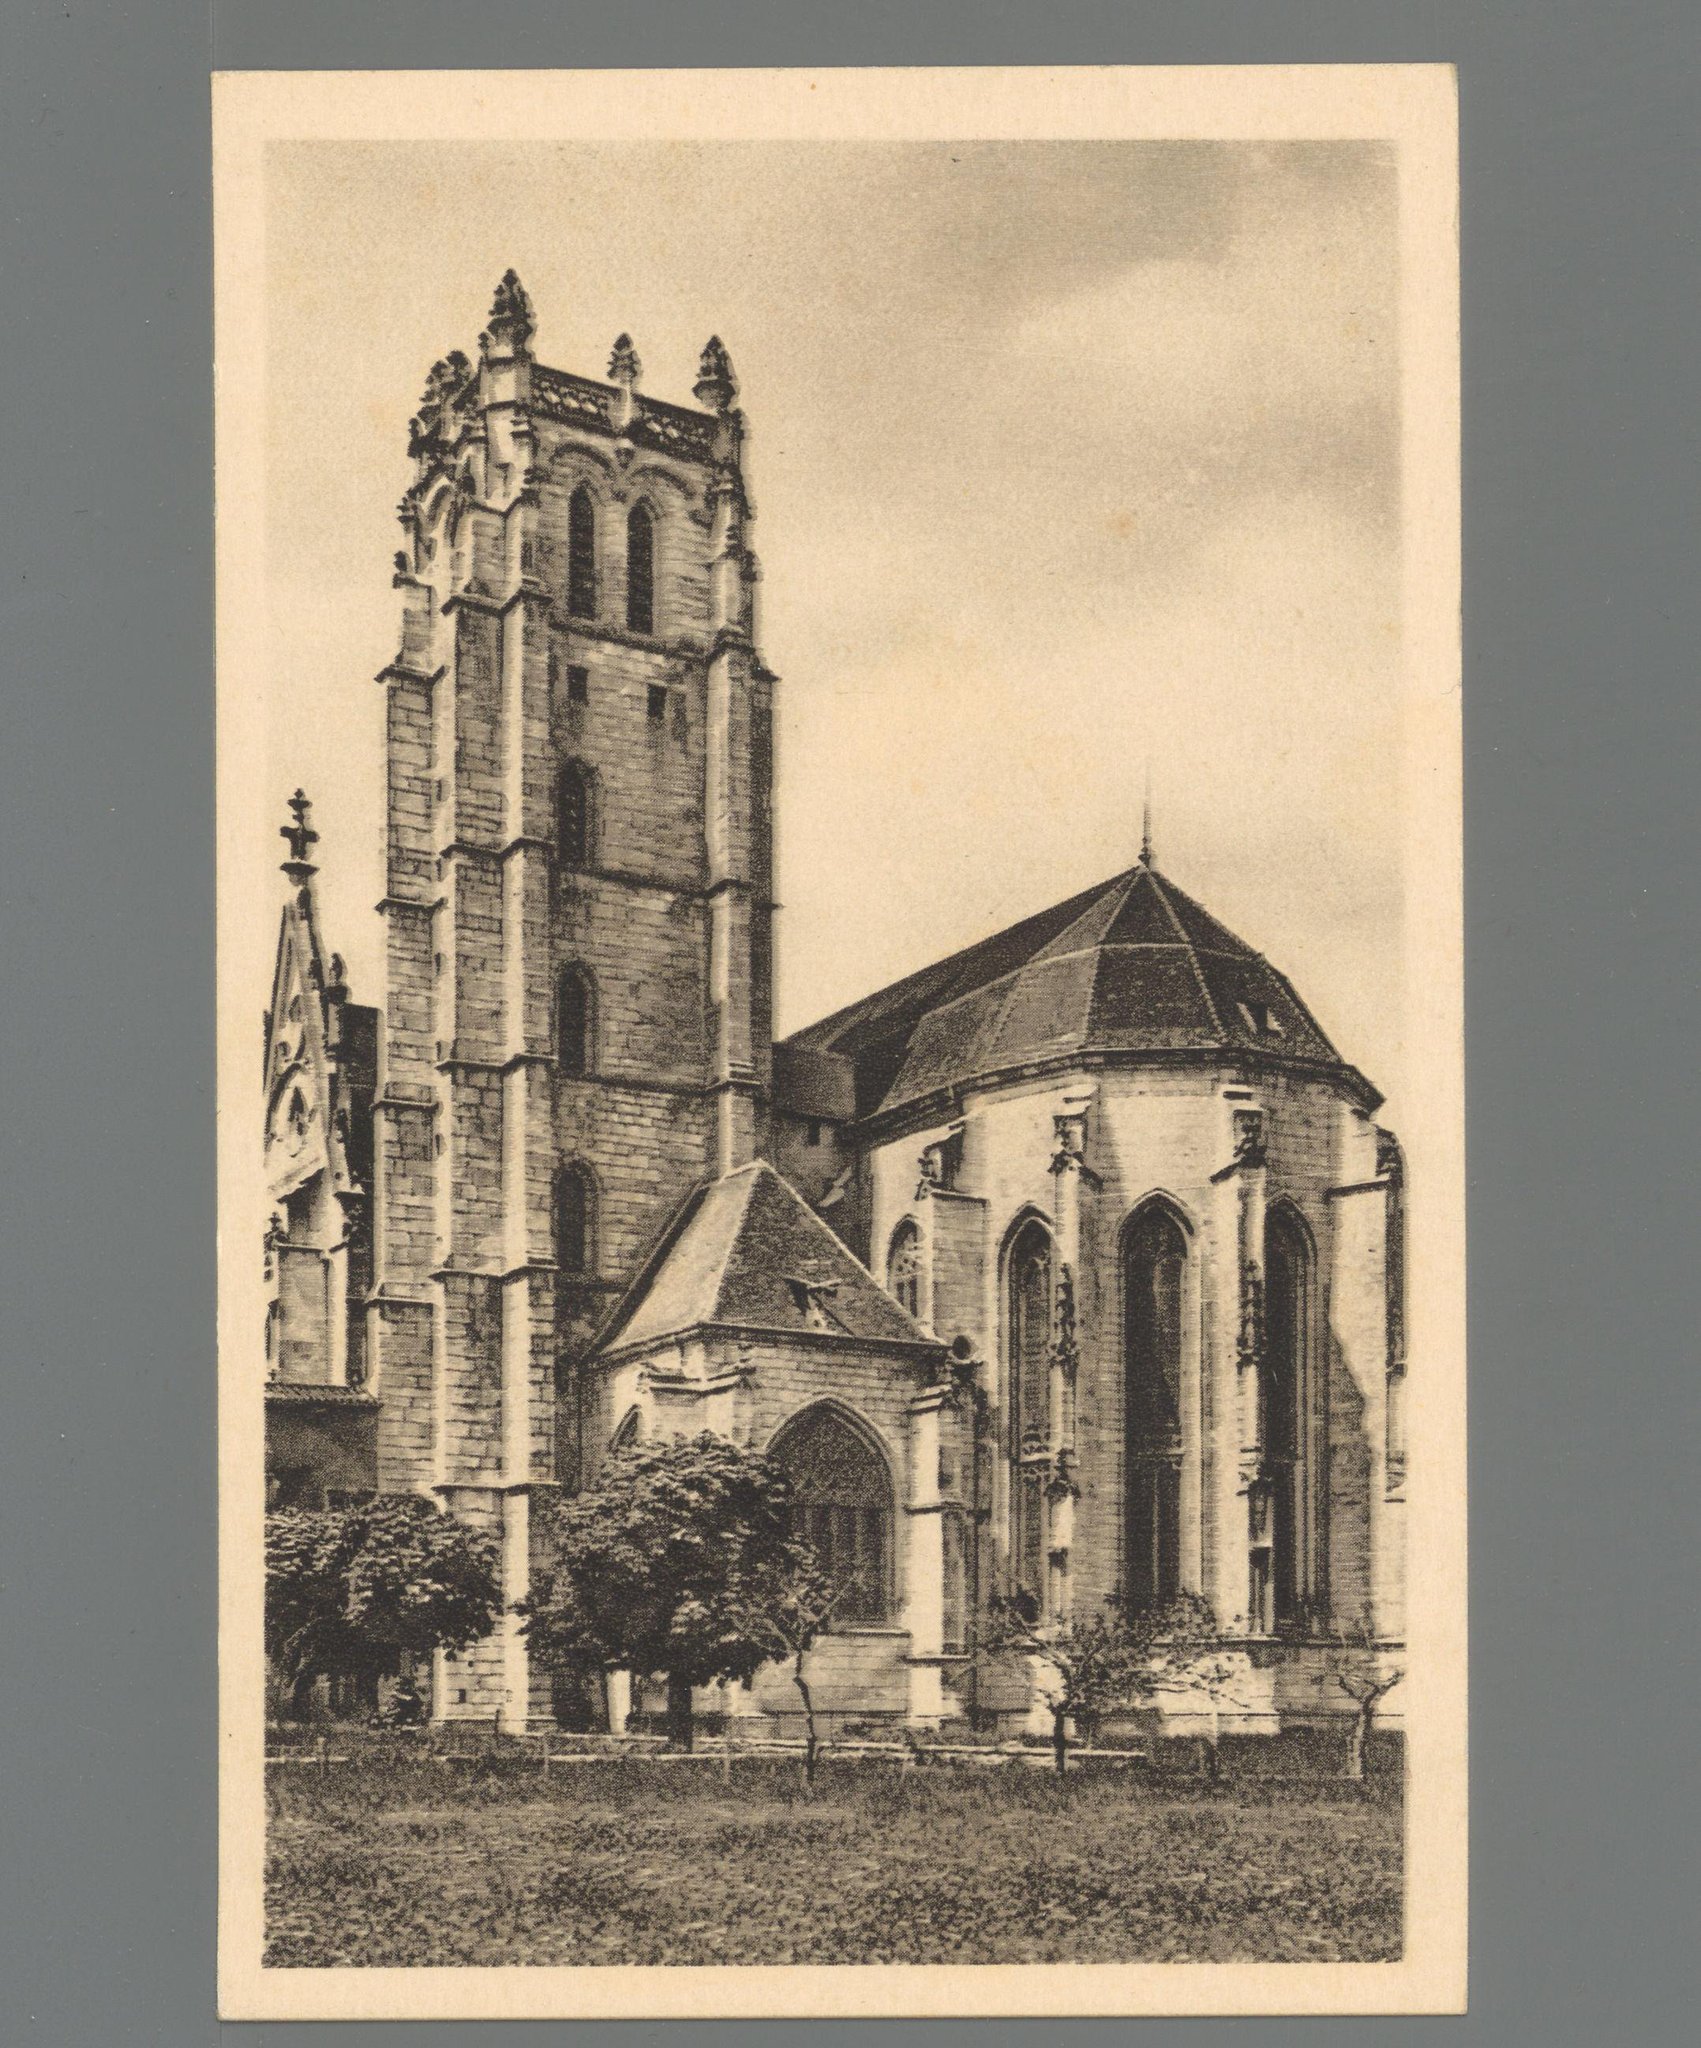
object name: photomechanical print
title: Eglise de Brou (Ain). Le Chevet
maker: Anonymous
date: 1913-1950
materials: cardboard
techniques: photograph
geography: paris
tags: church (exterior)